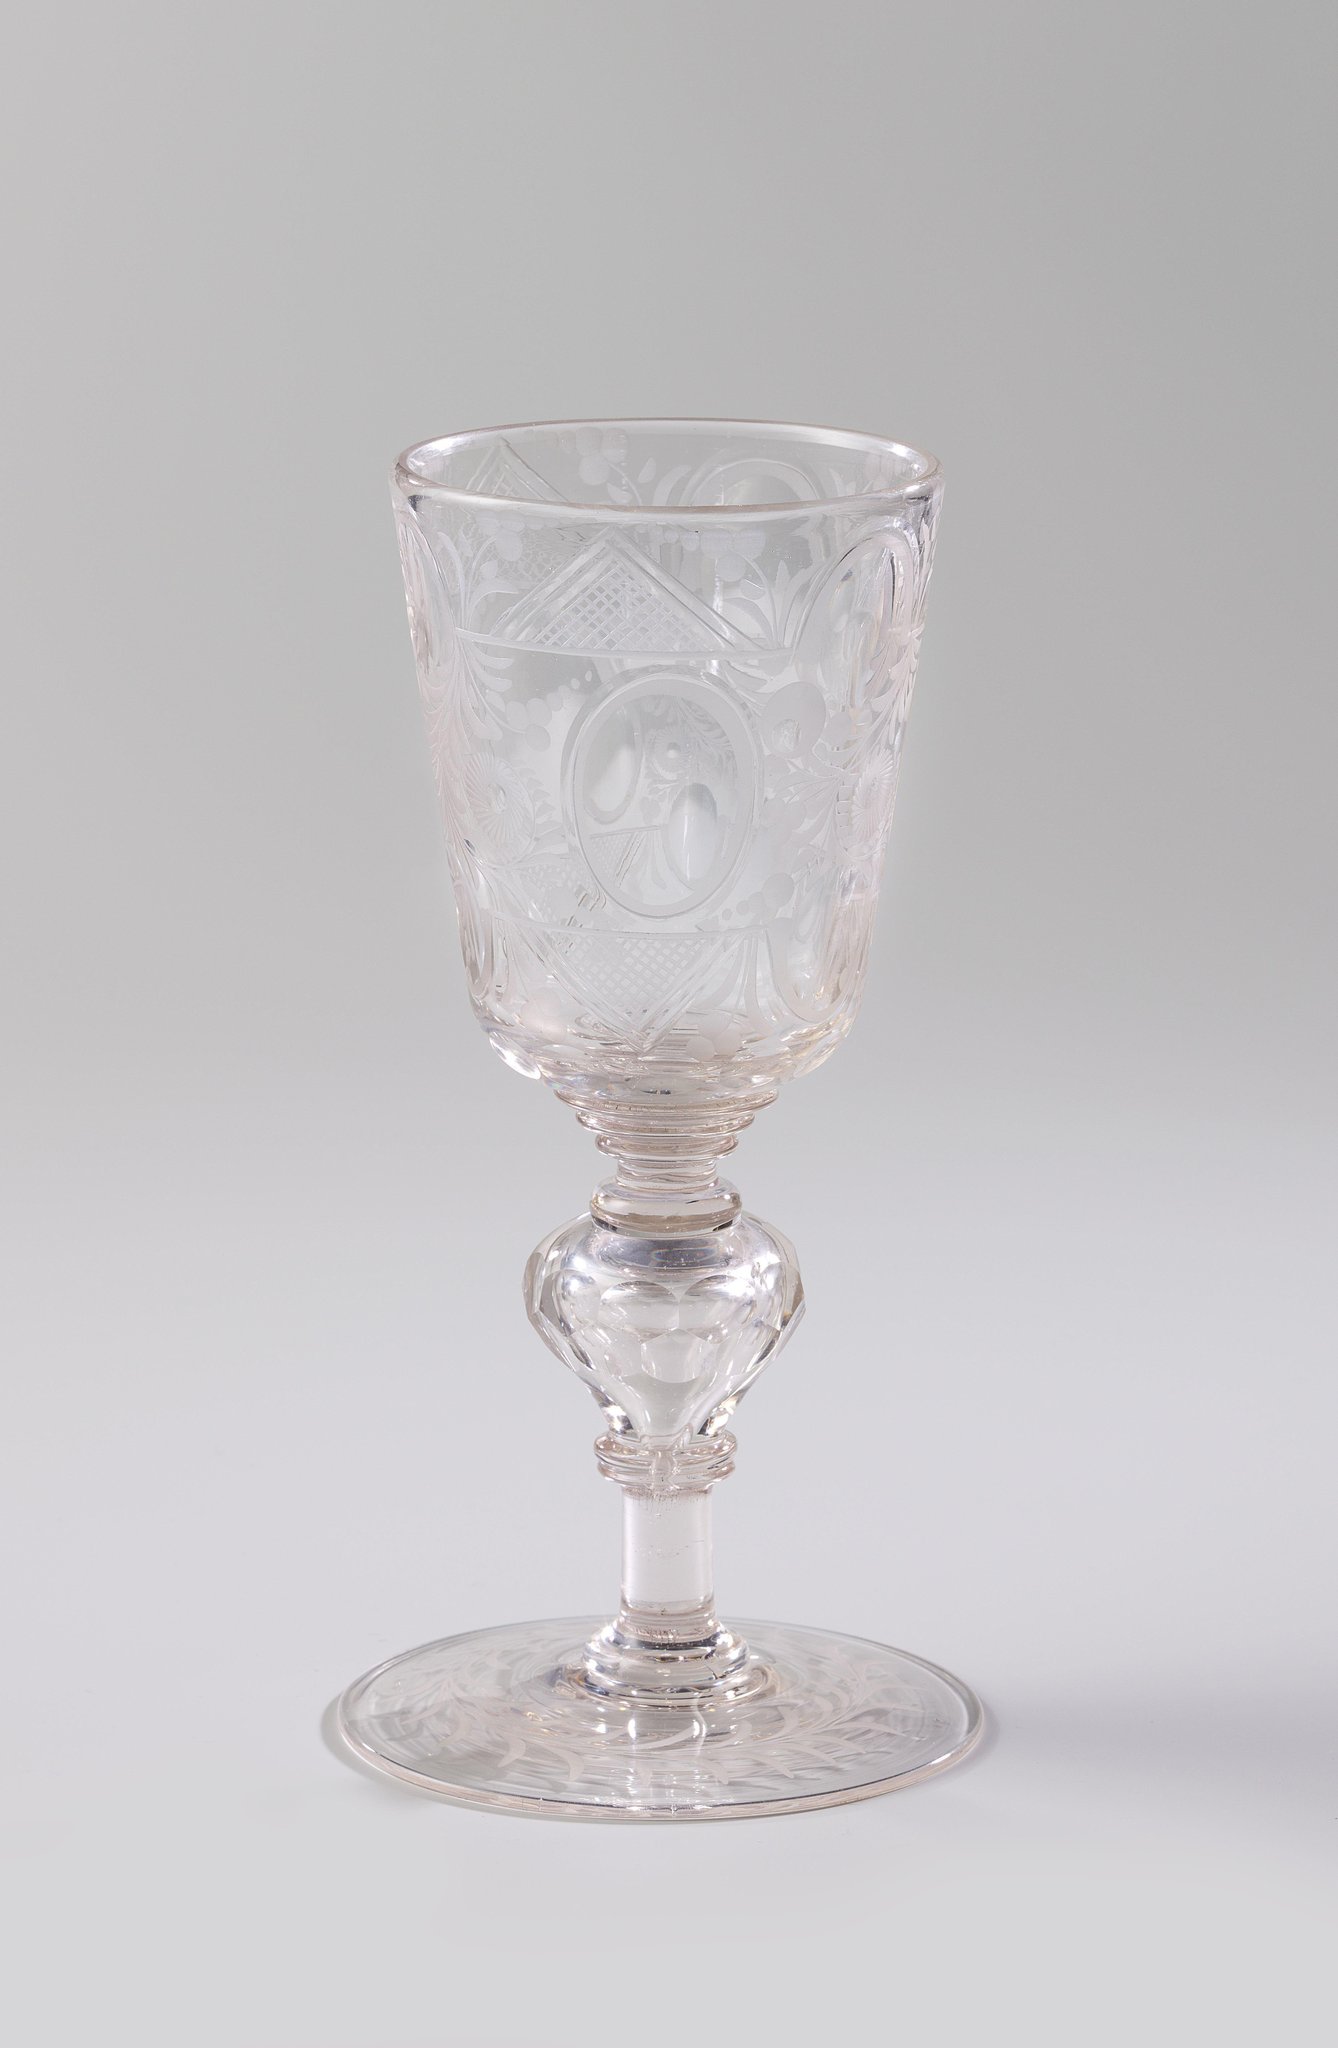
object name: goblet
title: Bokaal met bloemtakken, ovalen en driehoeken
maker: Anonymous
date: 1725-1750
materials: glass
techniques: glassblowing, grinding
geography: bohemia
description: Bokaal met conische voet, balustervormige stam met twee knopen en vijf schijven. Trechtervormige kelk met facetgeslepen, afgeronde onderzijde. Op de kelk drie bloemtakken met zonnebloemen en bessen tussen bogen, van elkaar gescheiden door ovalen tussen driehoeken met rasterwerk.